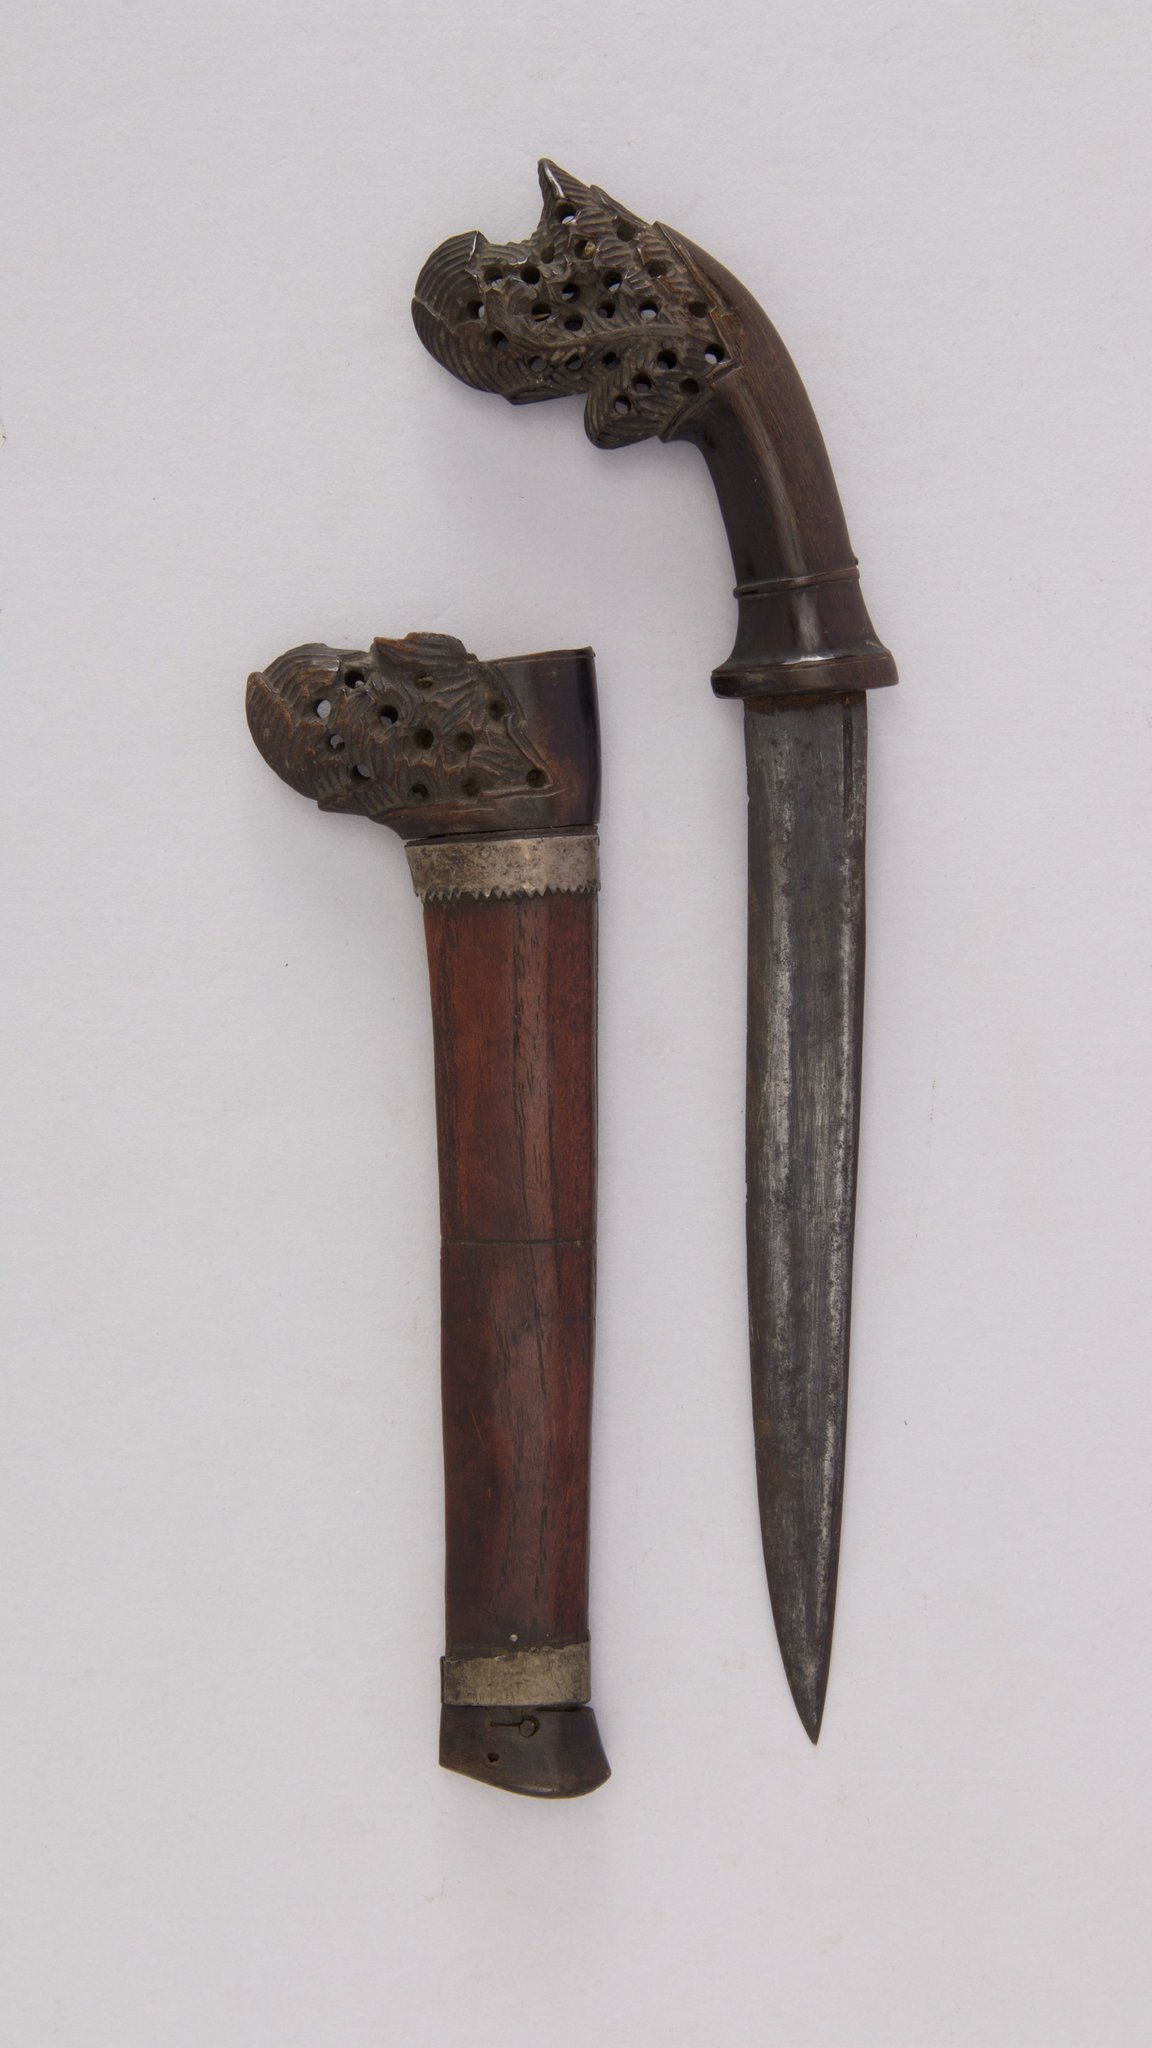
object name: dagger with sheath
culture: malayan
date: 1701-1900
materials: silver, steel, wood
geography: malaysia